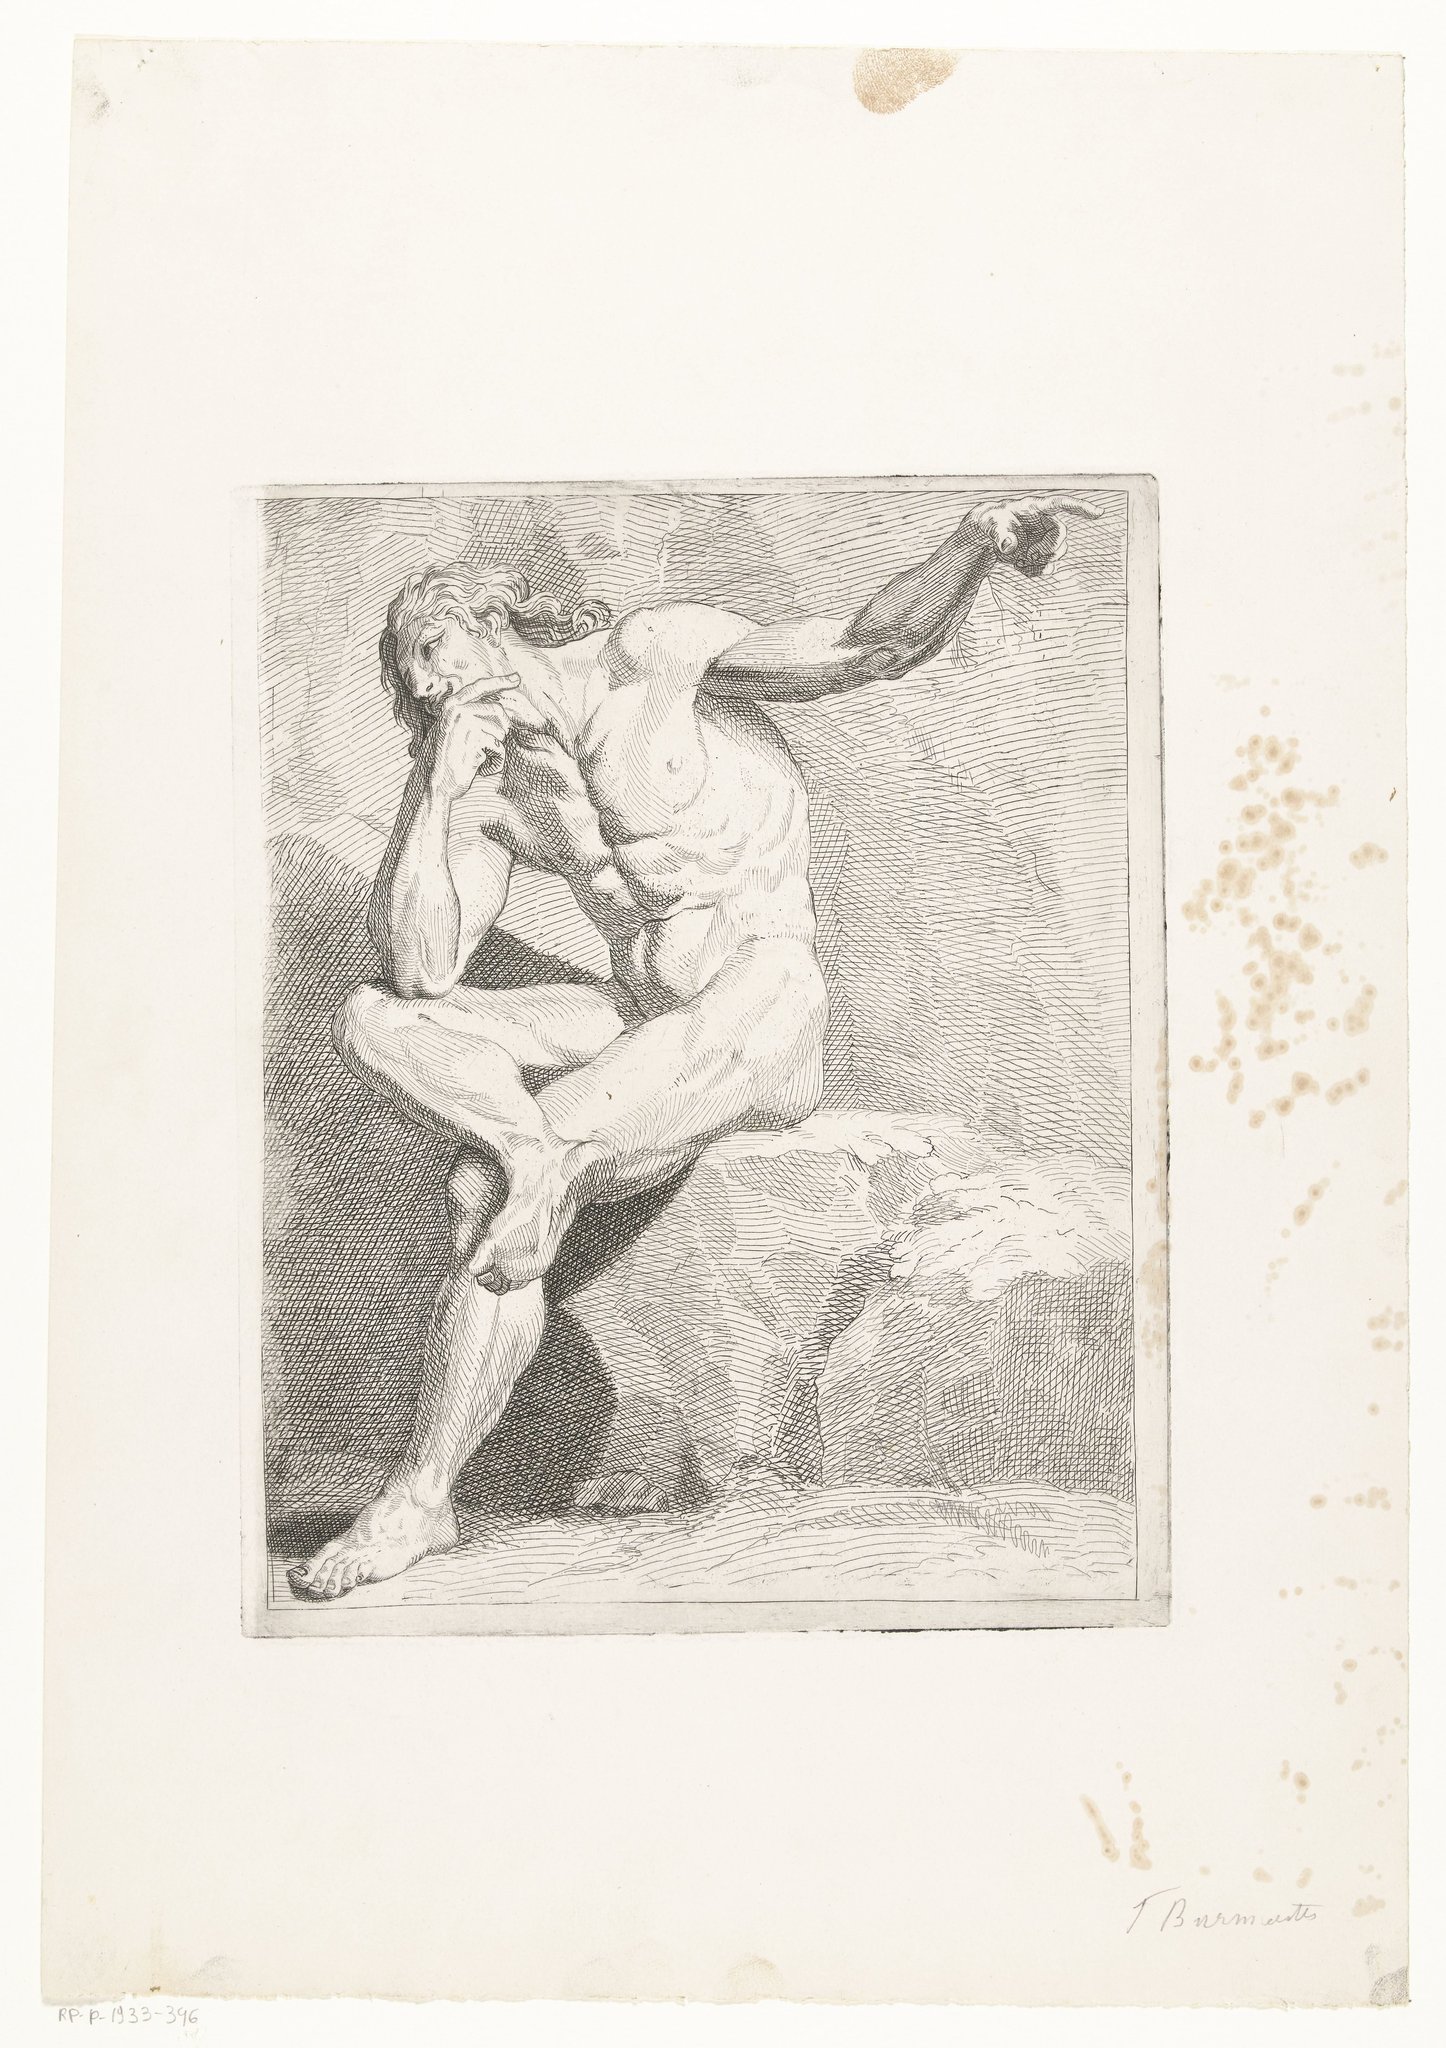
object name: print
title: Naakte jongeling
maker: friedrich wilhelm burmeister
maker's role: print maker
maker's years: 1845-1933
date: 1855-1915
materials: paper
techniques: engraving, etching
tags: the ages of man (+ nude human being), the (nude) human figure; 'corpo humano' (ripa) (+ young male (human being))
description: Naakte jongeling op een rotsblok. Zijn blik is naar links gericht. Hij wijst met zijn linkerhand naar rechts.